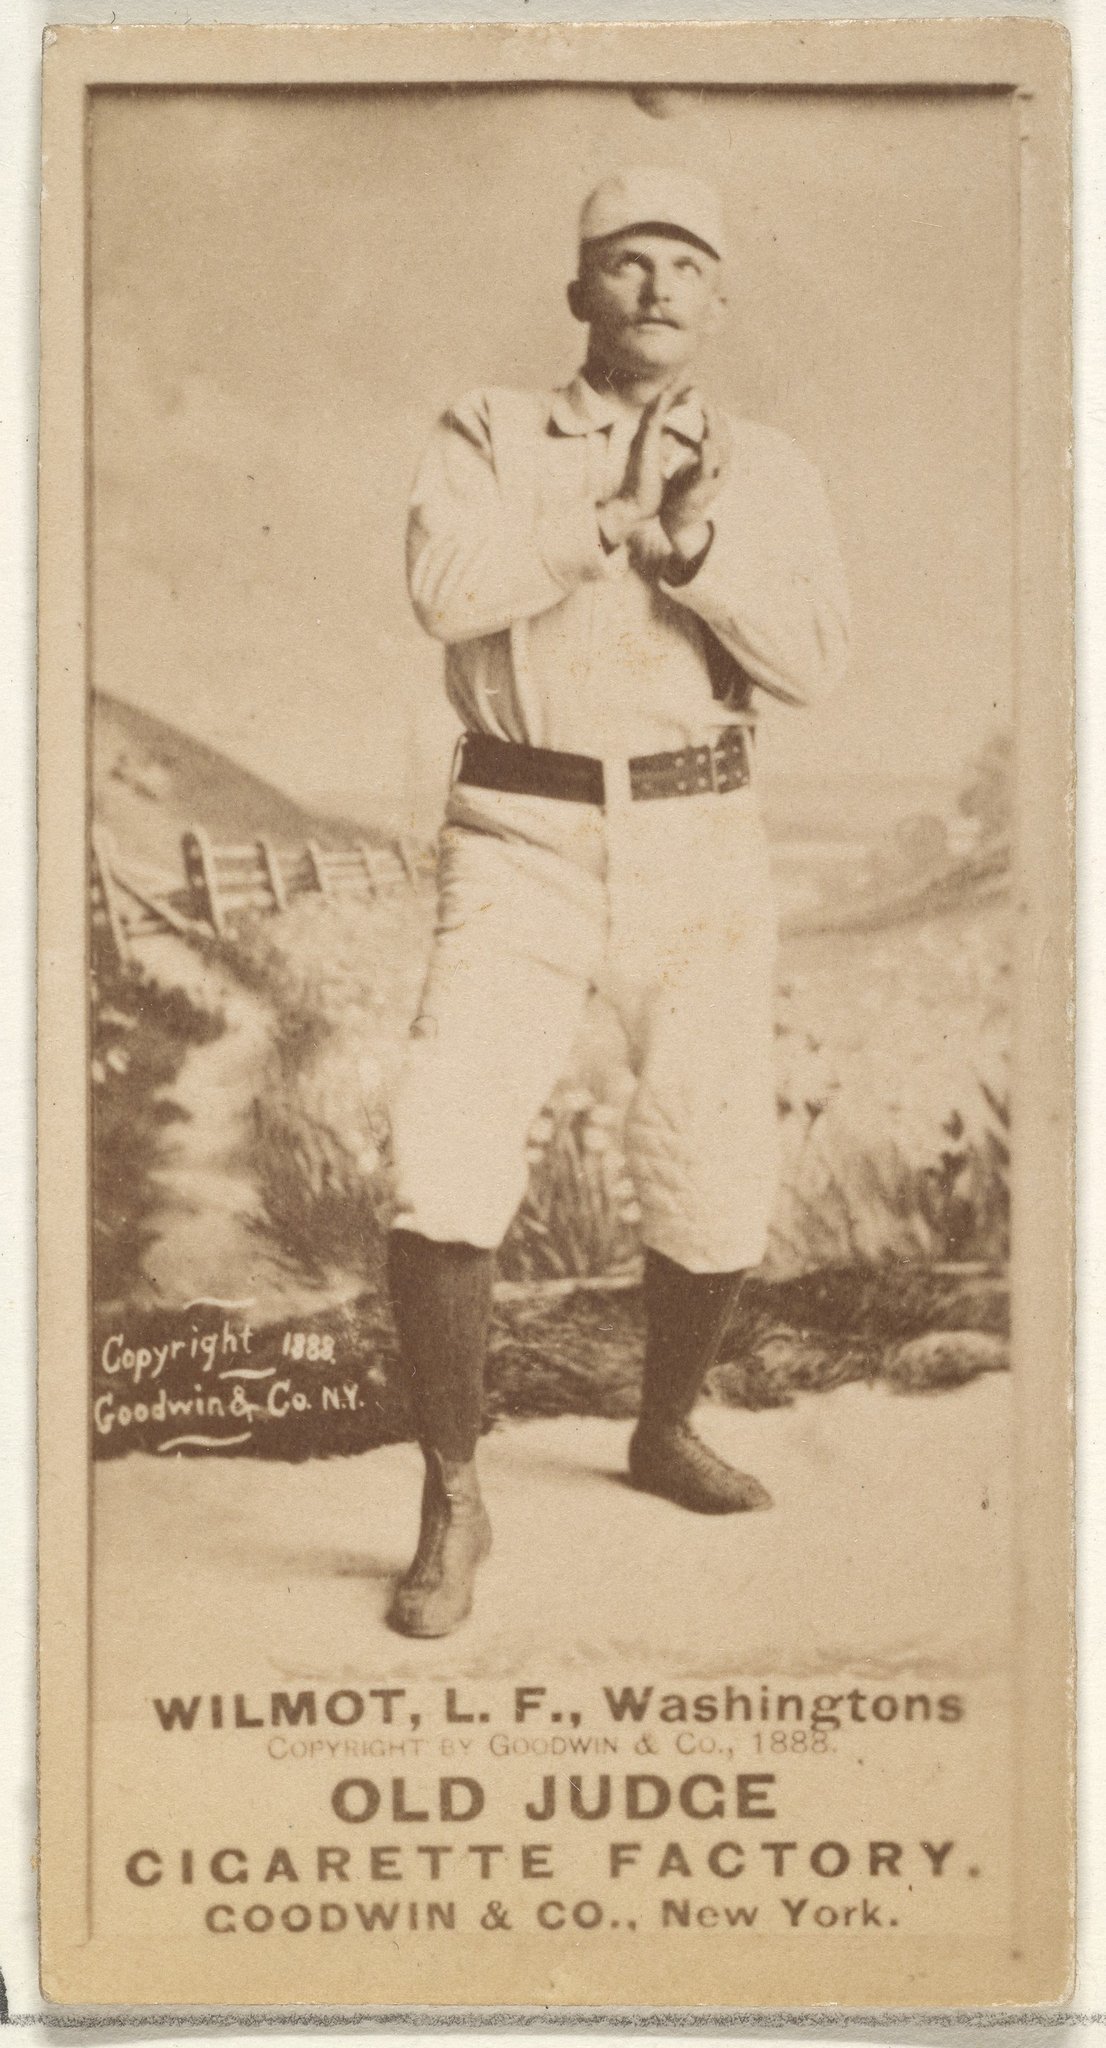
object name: baseball card, photograph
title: Walter Robert "Walt" Wilmot, Left Field, Washington Nationals, from the Old Judge series (N172) for Old Judge Cigarettes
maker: goodwin & company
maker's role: publisher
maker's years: 1850-1950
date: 1888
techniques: albumen silver print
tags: men,portraits,baseball,athletes